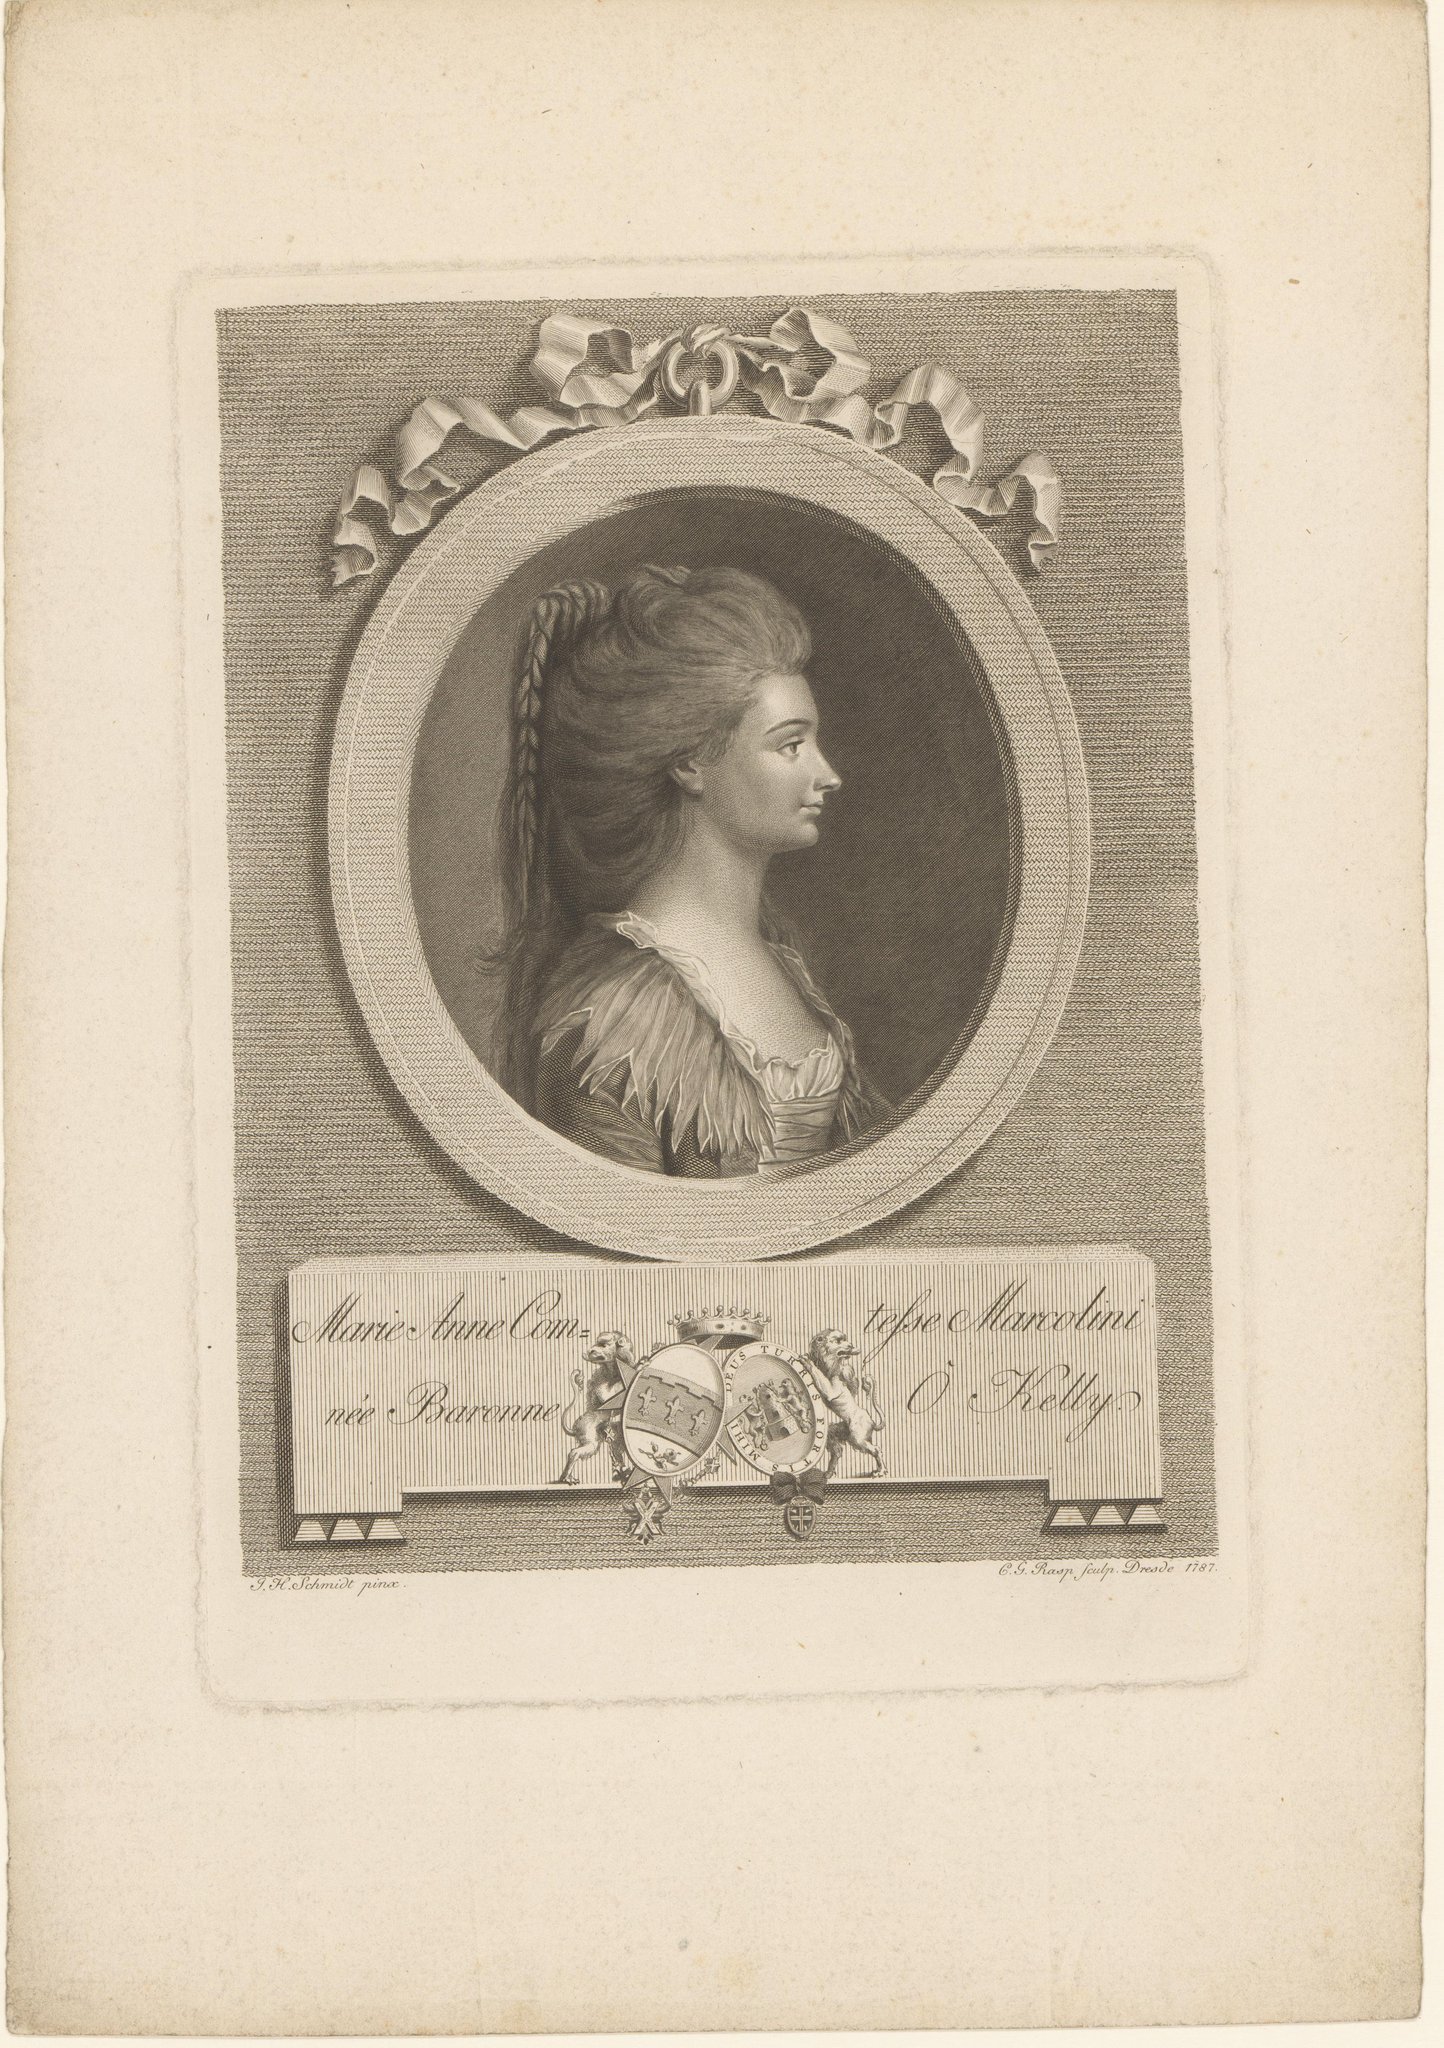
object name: print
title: Portret van Marie Anne, comtesse Marcolini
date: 1787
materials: paper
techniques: engraving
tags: historical persons - bb - woman, armorial bearing, heraldry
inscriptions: collector's mark: Lugt 2228